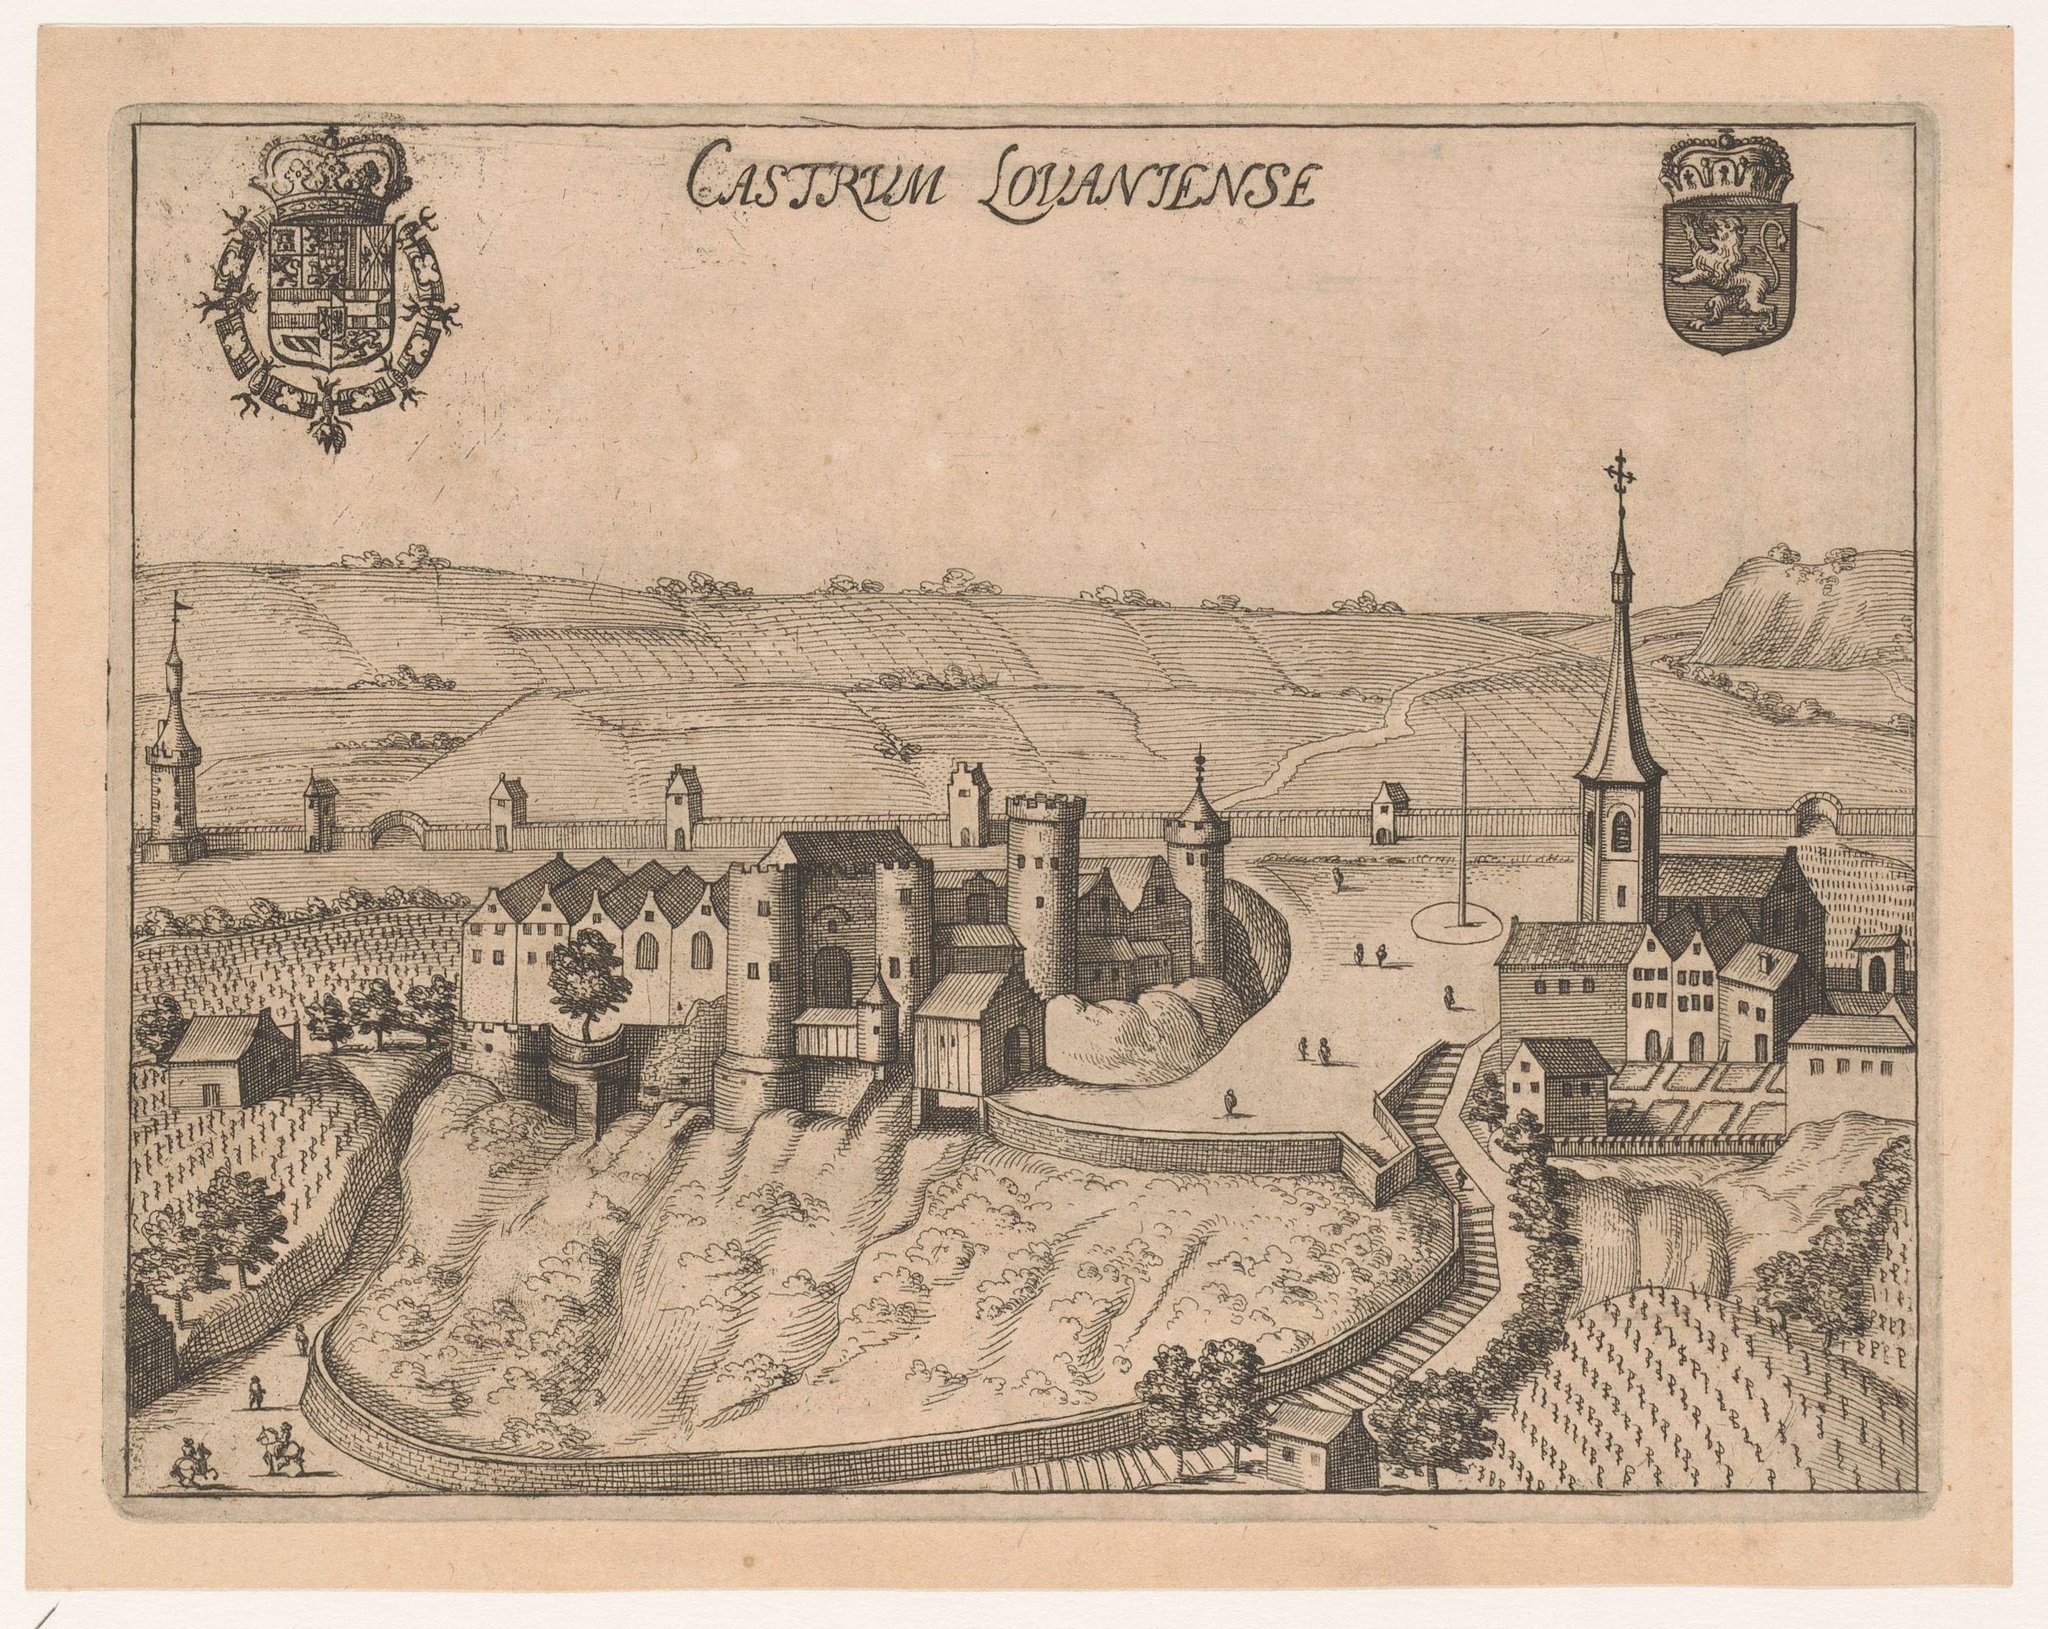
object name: print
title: Castrum Lovaniense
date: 1659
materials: paper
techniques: etching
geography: brussels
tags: castle, landscape with tower or castle, louvain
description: Prent uit: Sanderus, Antonius. Chorographia sacra Brabantiae (...). Brussel: Philips Vleugaert, 1659.